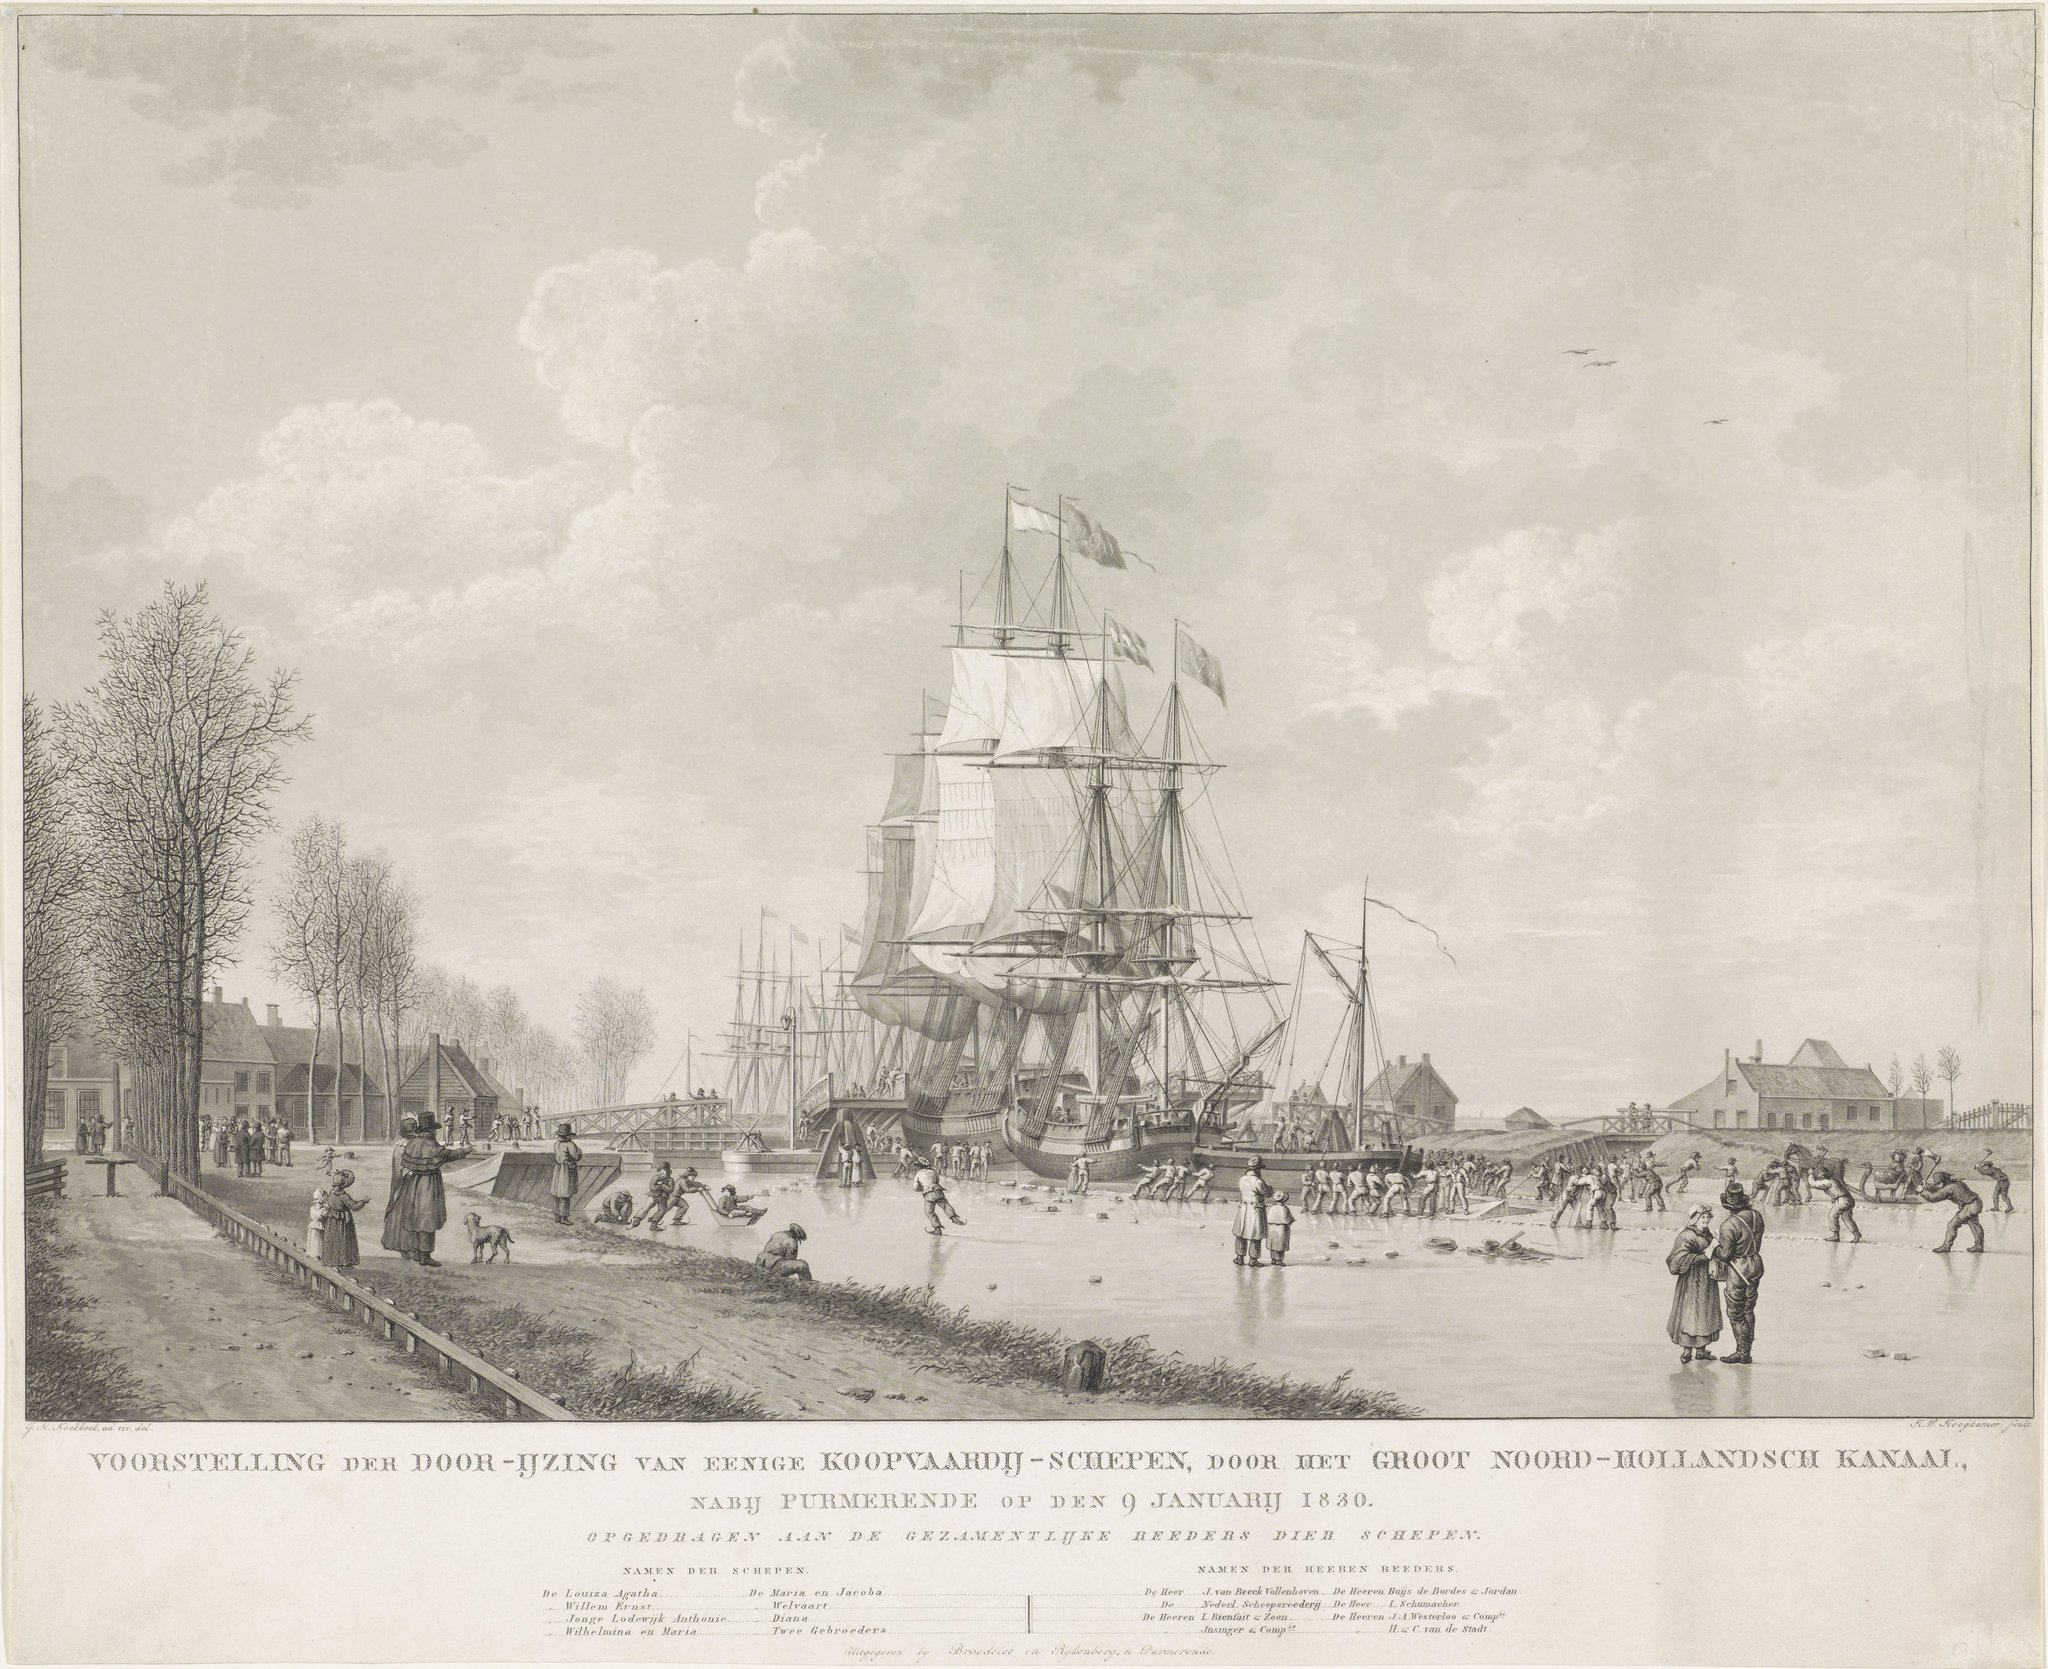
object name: print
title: Vrijmaken van enige schepen uit het ijs van het Noordhollands Kanaal, 1830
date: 1830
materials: paper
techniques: aquatint, etching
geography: purmerend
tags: sailing-ship, sailing-boat, ice ~ freezing weather, skates (winter sports)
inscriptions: collector's mark: Lugt 2228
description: Het vrijmaken van enige vastgevroren koopvaardijschepen uit het ijs van het Noordhollands Kanaal bij Purmerend, 9 januari 1830. Groepen mannen zijn bezig grote stukken uit het ijs rondom de zeilschepen los te hakken. Op het ijs en op de kades kijken omstanders toe. Links huizen van het dorp Purmerend. In het onderschrift de namen van de acht koopvaardijschepen en hun reders.